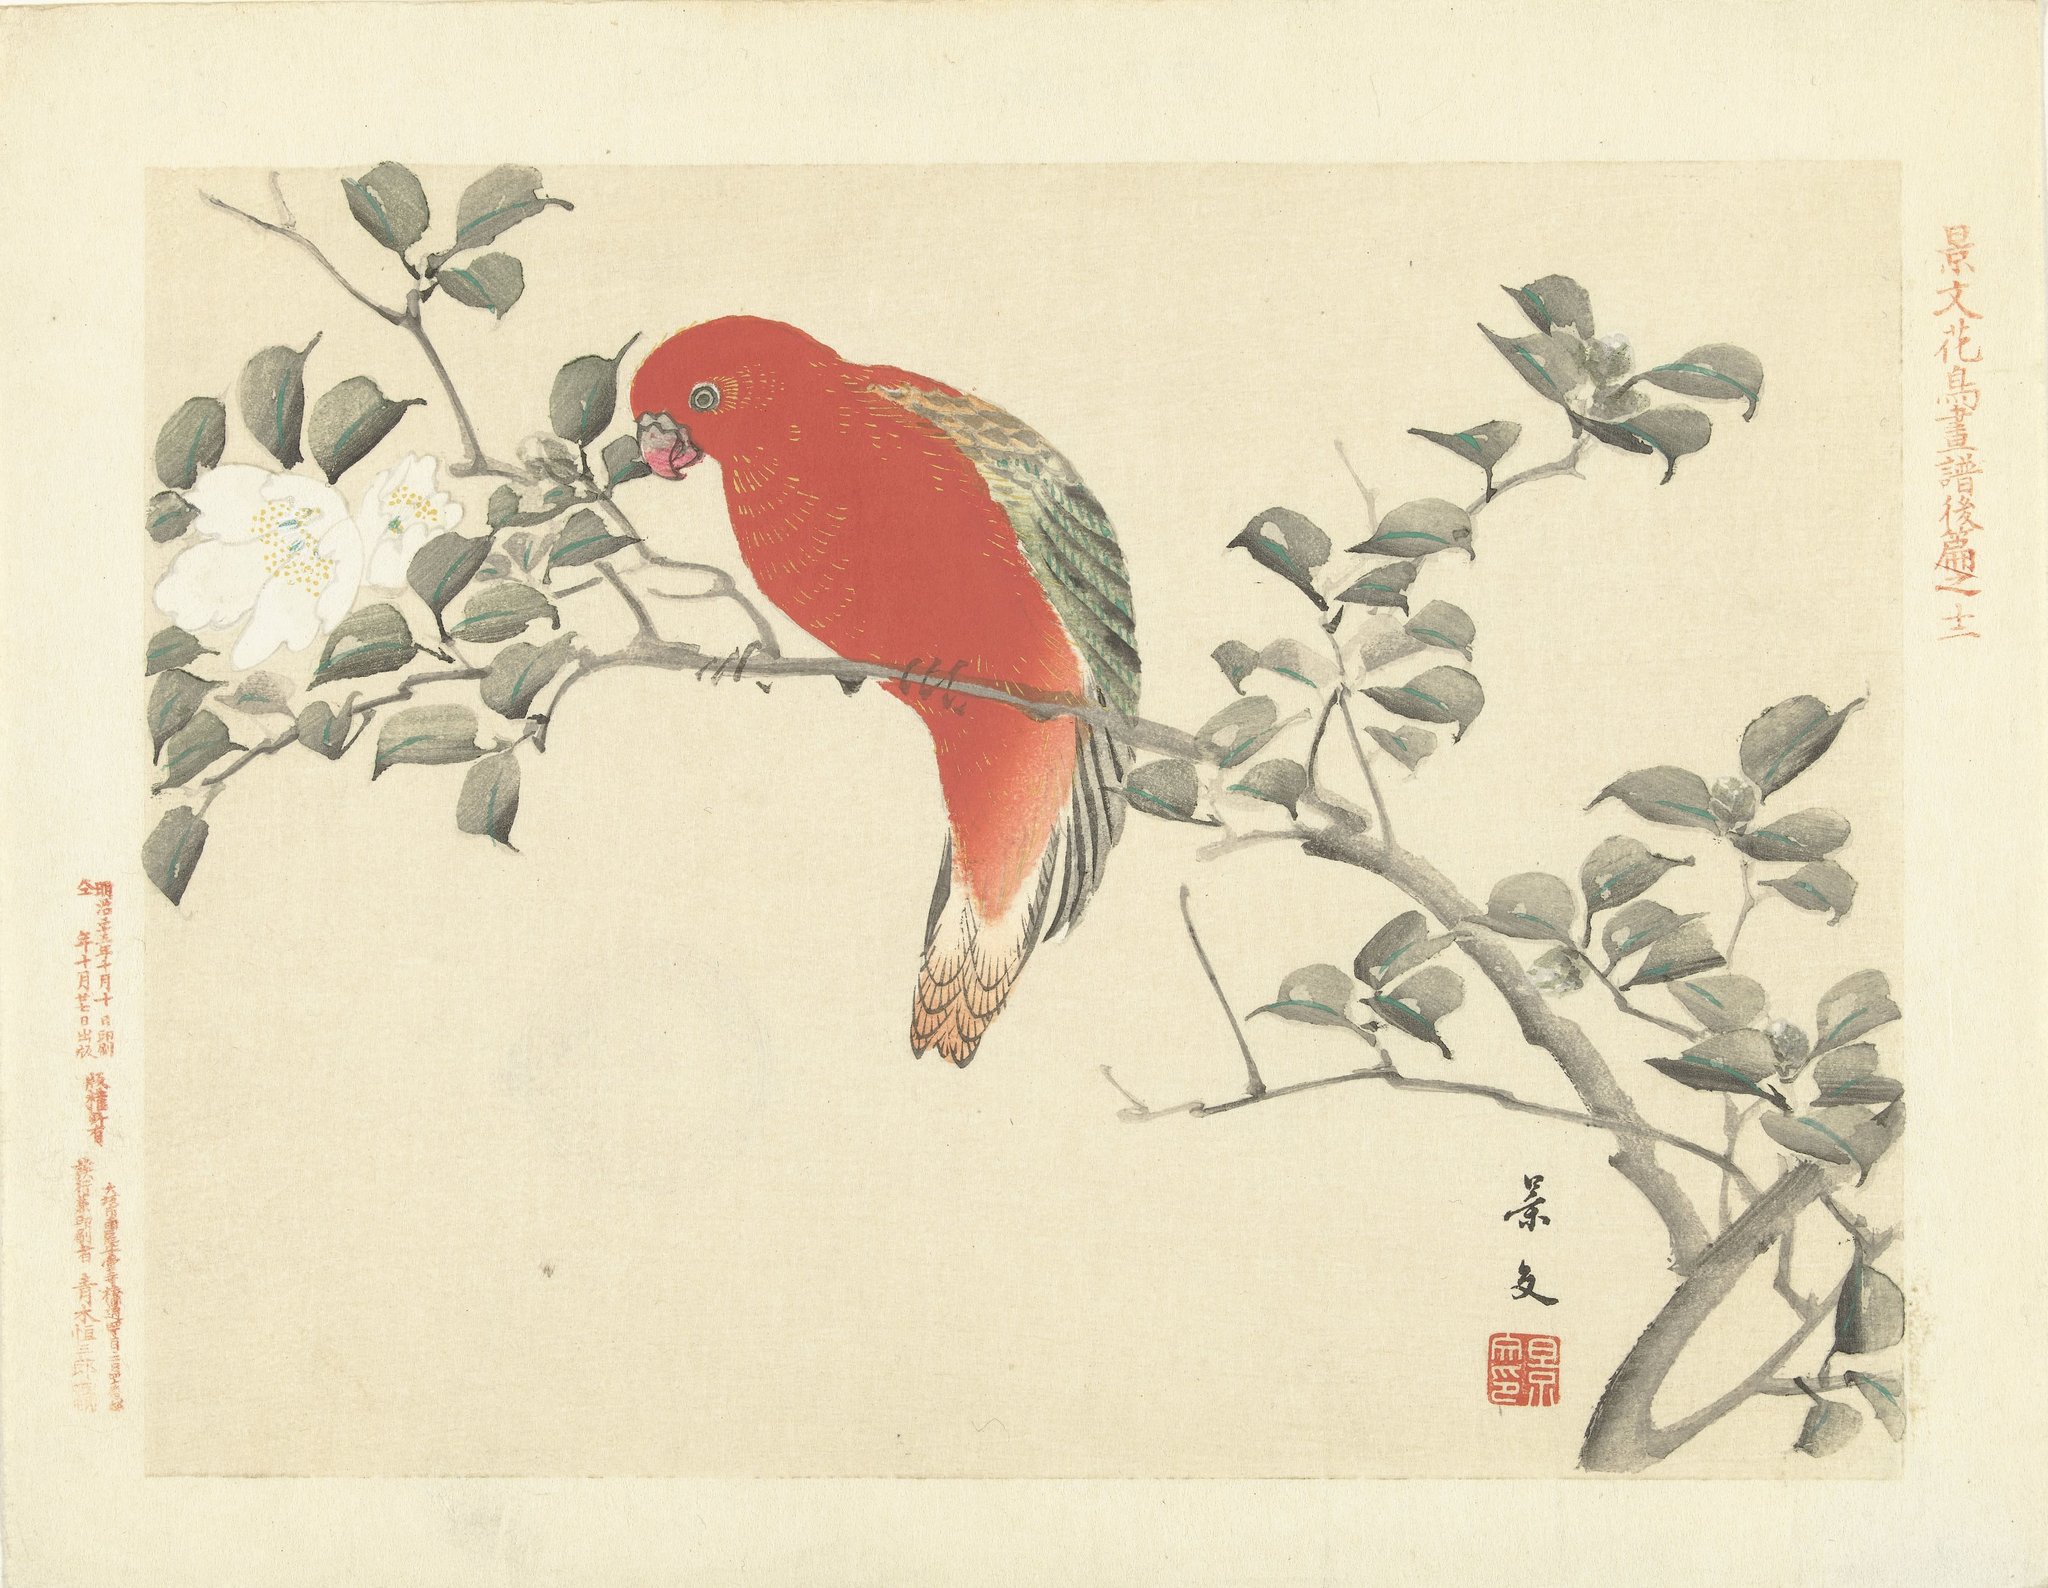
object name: print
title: Bloemen- en vogelschetsen van Keibun- deel drie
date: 1810-1892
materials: paper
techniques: woodcut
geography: japan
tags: plants; vegetation, ornamental birds: parrot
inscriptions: collector's mark: ‘Rijksschool voor kunstnijverheid’ Lugt 3937, collector's mark: Lugt 2228